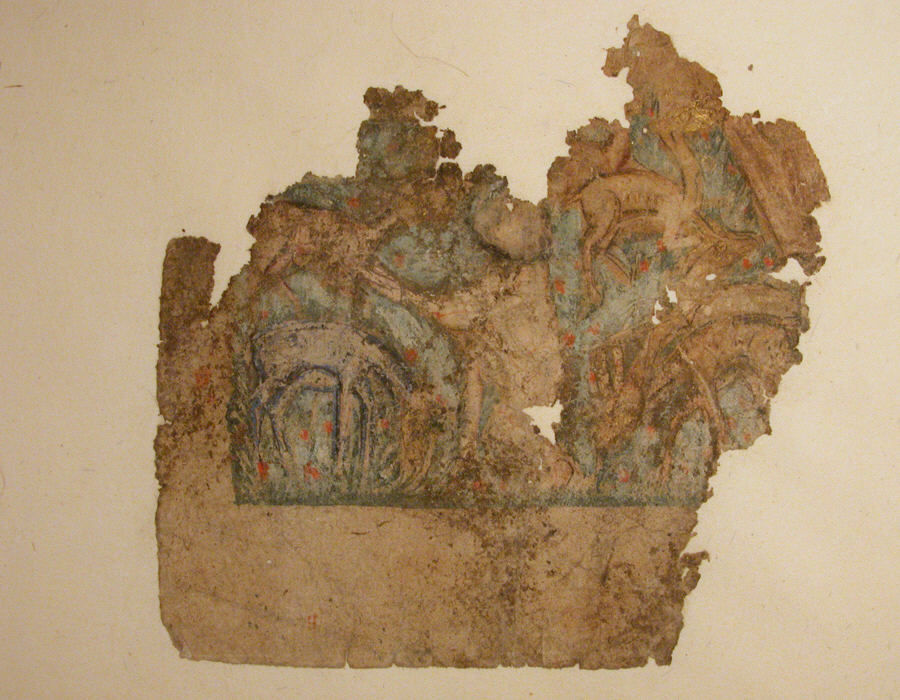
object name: folio from an illustrated manuscript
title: "Animals (Deer?) Feeding Under Trees", Folio Fragment from a Dispersed Manuscript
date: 1001-1200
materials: gold, paper, watercolor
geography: egypt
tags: animals